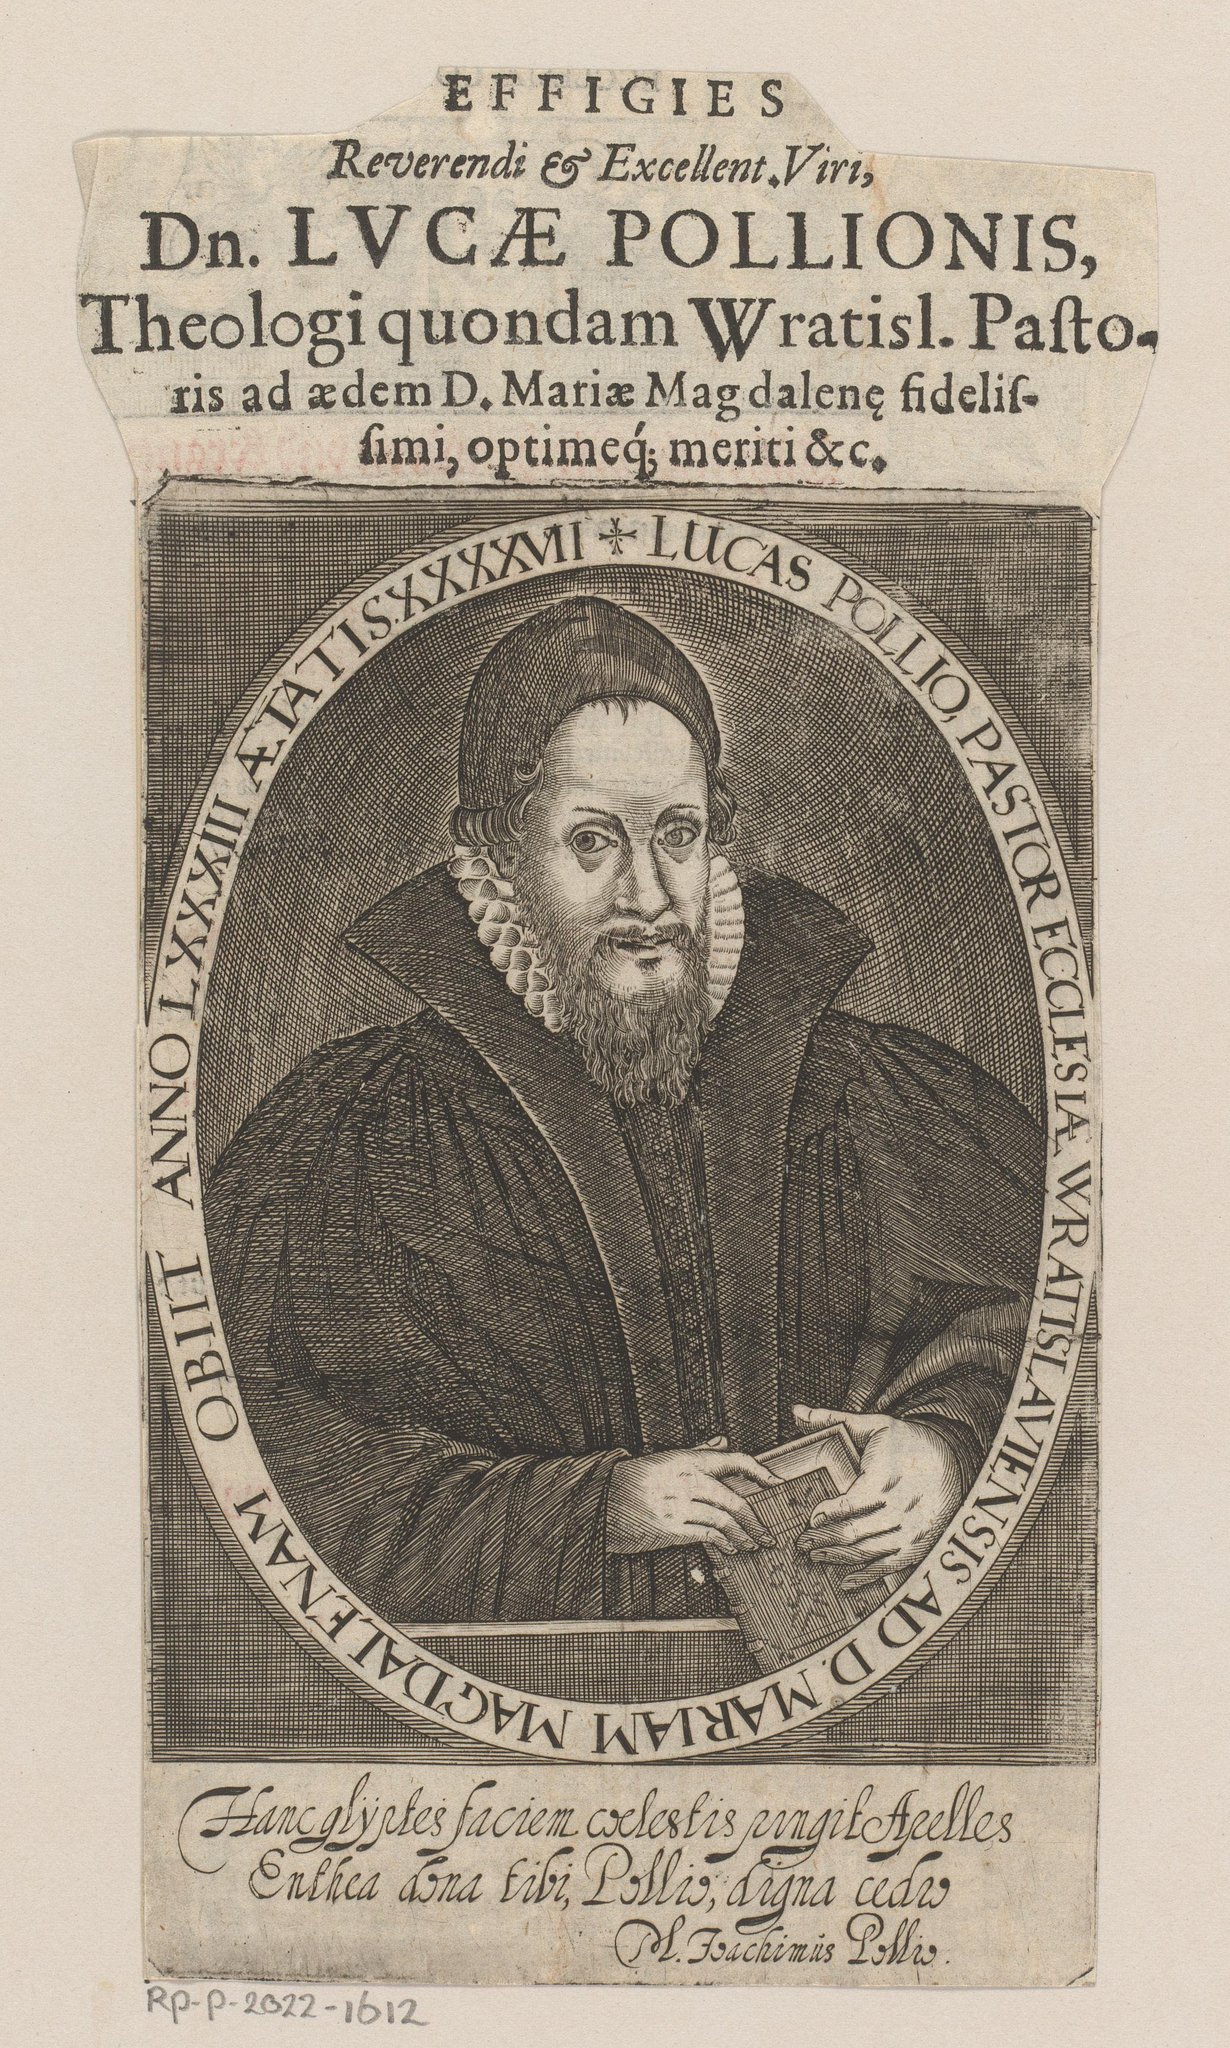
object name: book illustration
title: Portret van Lucas Pollio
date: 1620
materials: paper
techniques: engraving, letterpress printing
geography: leipzig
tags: theologian, historical persons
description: Prent uit: Pollio, Lucas. Ordentliche Erklärung der gewöhnlichen aller heiligen Sonn- und Festtage das ganze ausgehende Jahr über (...). Leipzig: Abraham Lemberg, 1620.